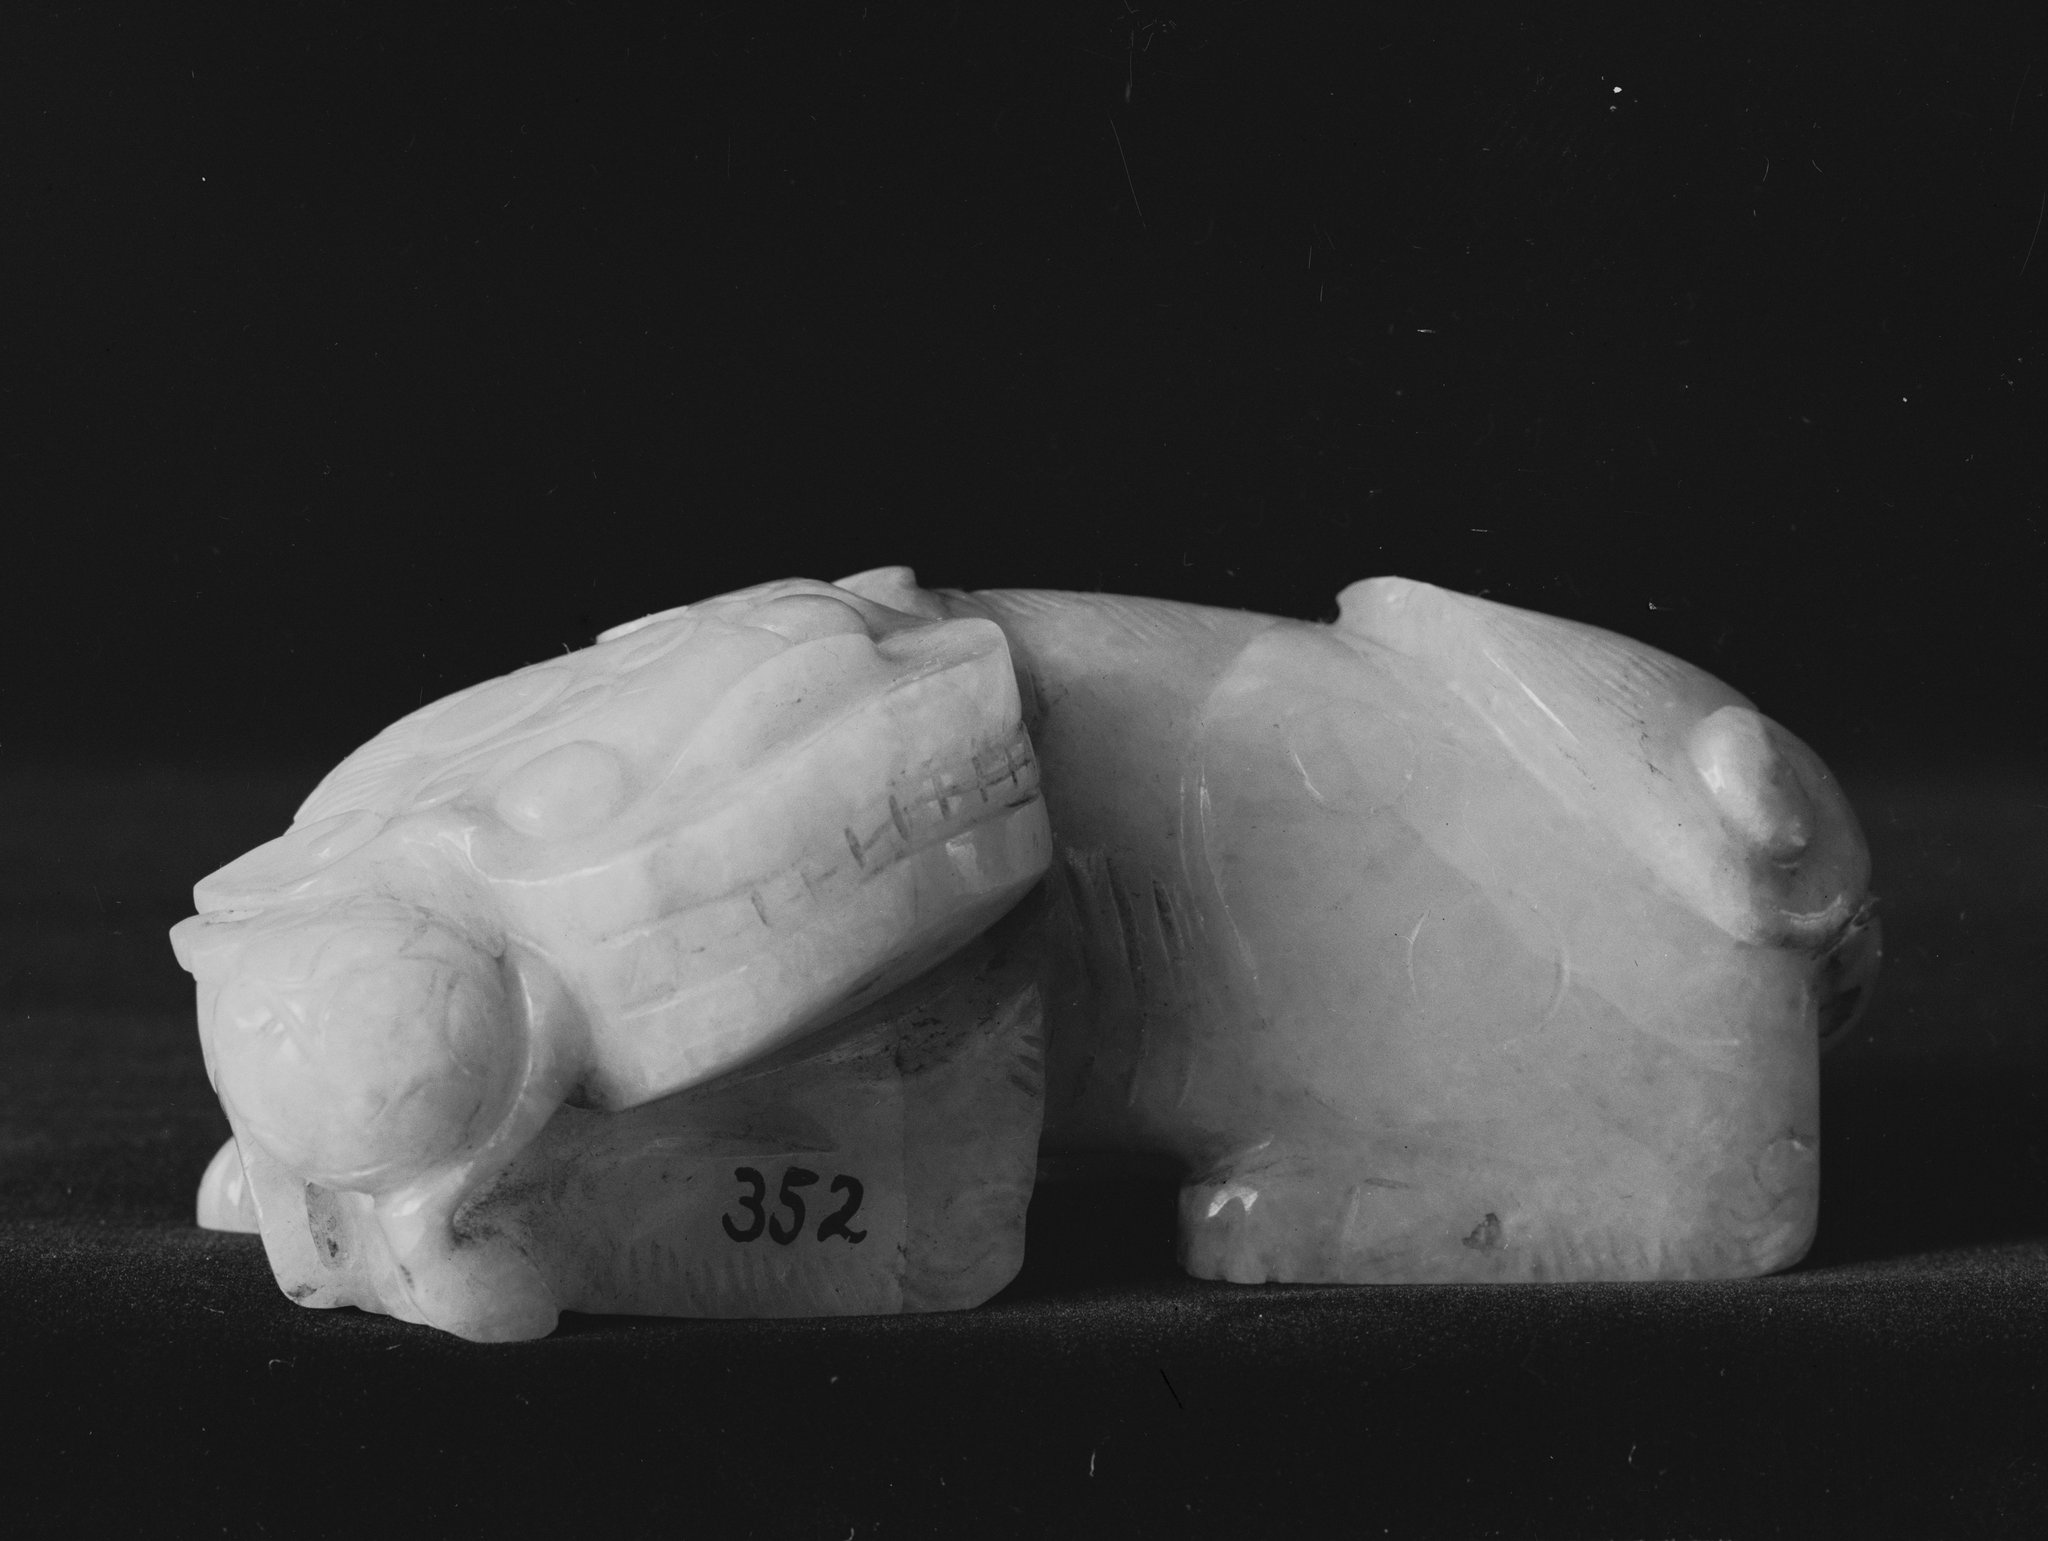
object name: lion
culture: chinese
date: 1300-1367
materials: jade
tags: lions